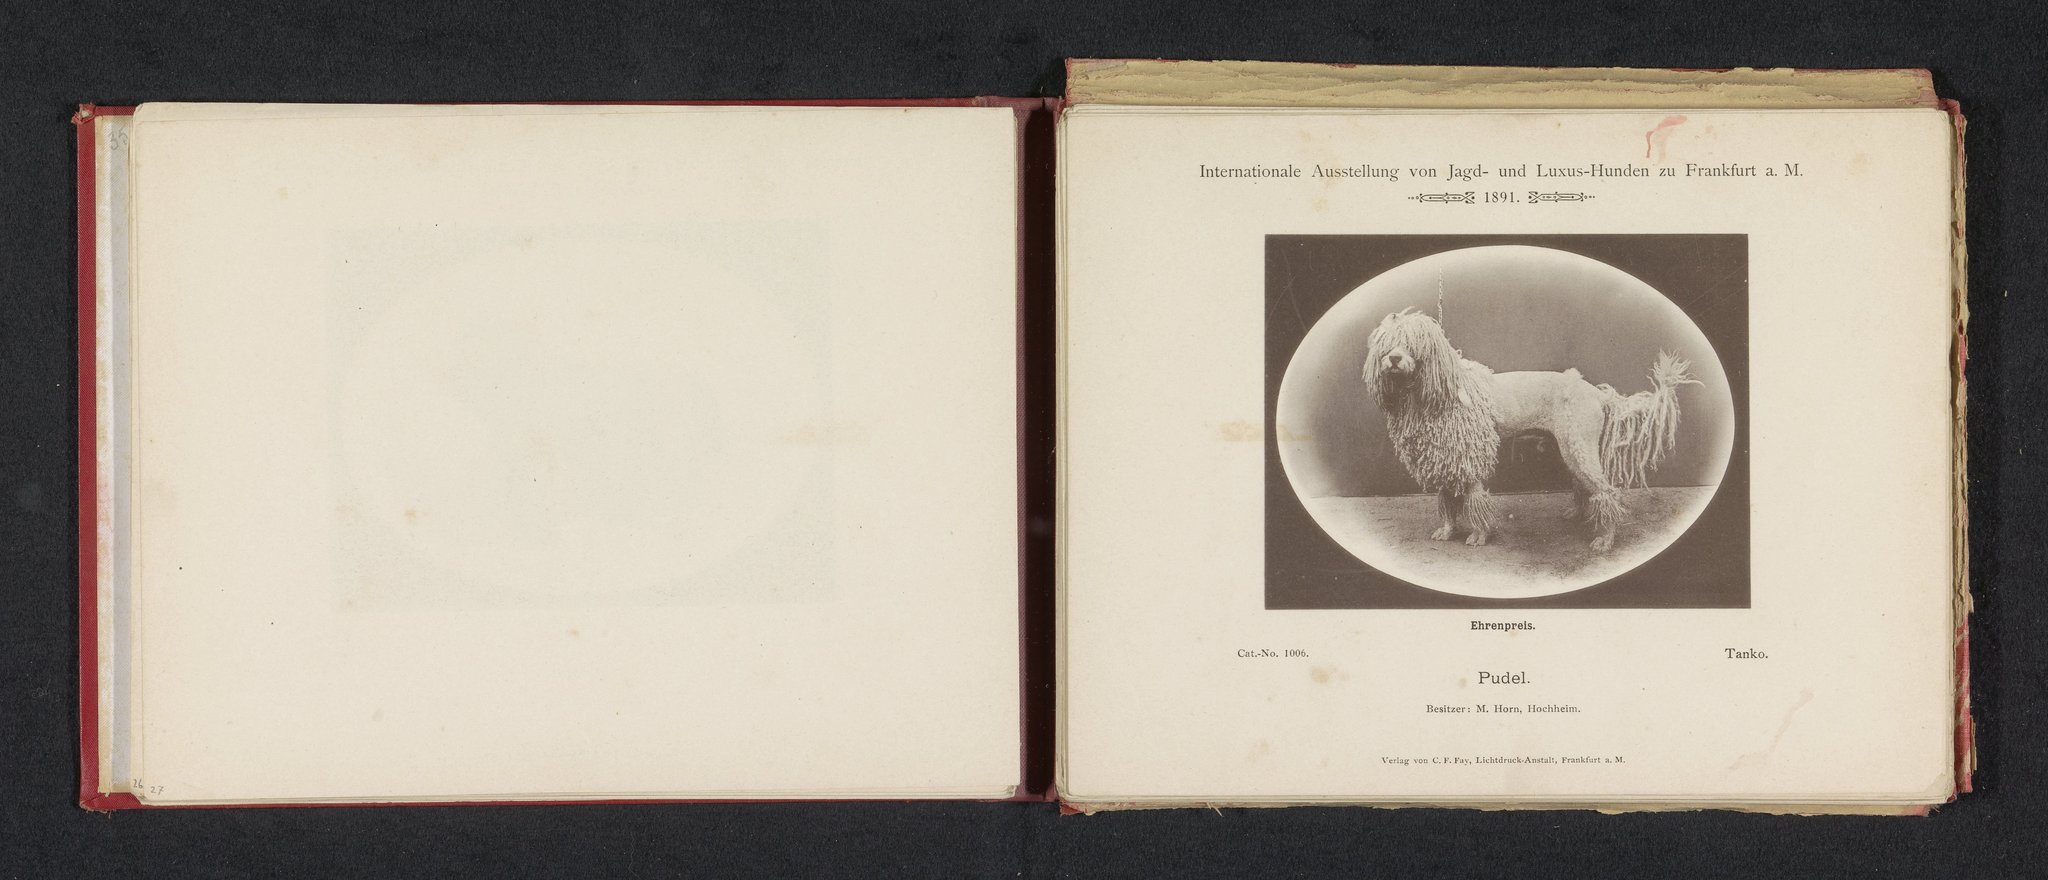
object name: photomechanical print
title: Internationale Ausstellung von Jagd- und Luxus-Hunden zu Frankfurt a. M. 1891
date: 1891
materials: paper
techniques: photograph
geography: frankfurt am main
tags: dog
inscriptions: inscription: ‘Ehrenpreis. Tanko. Besitzer : M. Horn, Hochheim.’, number: ‘Cat.-No. 1006.’